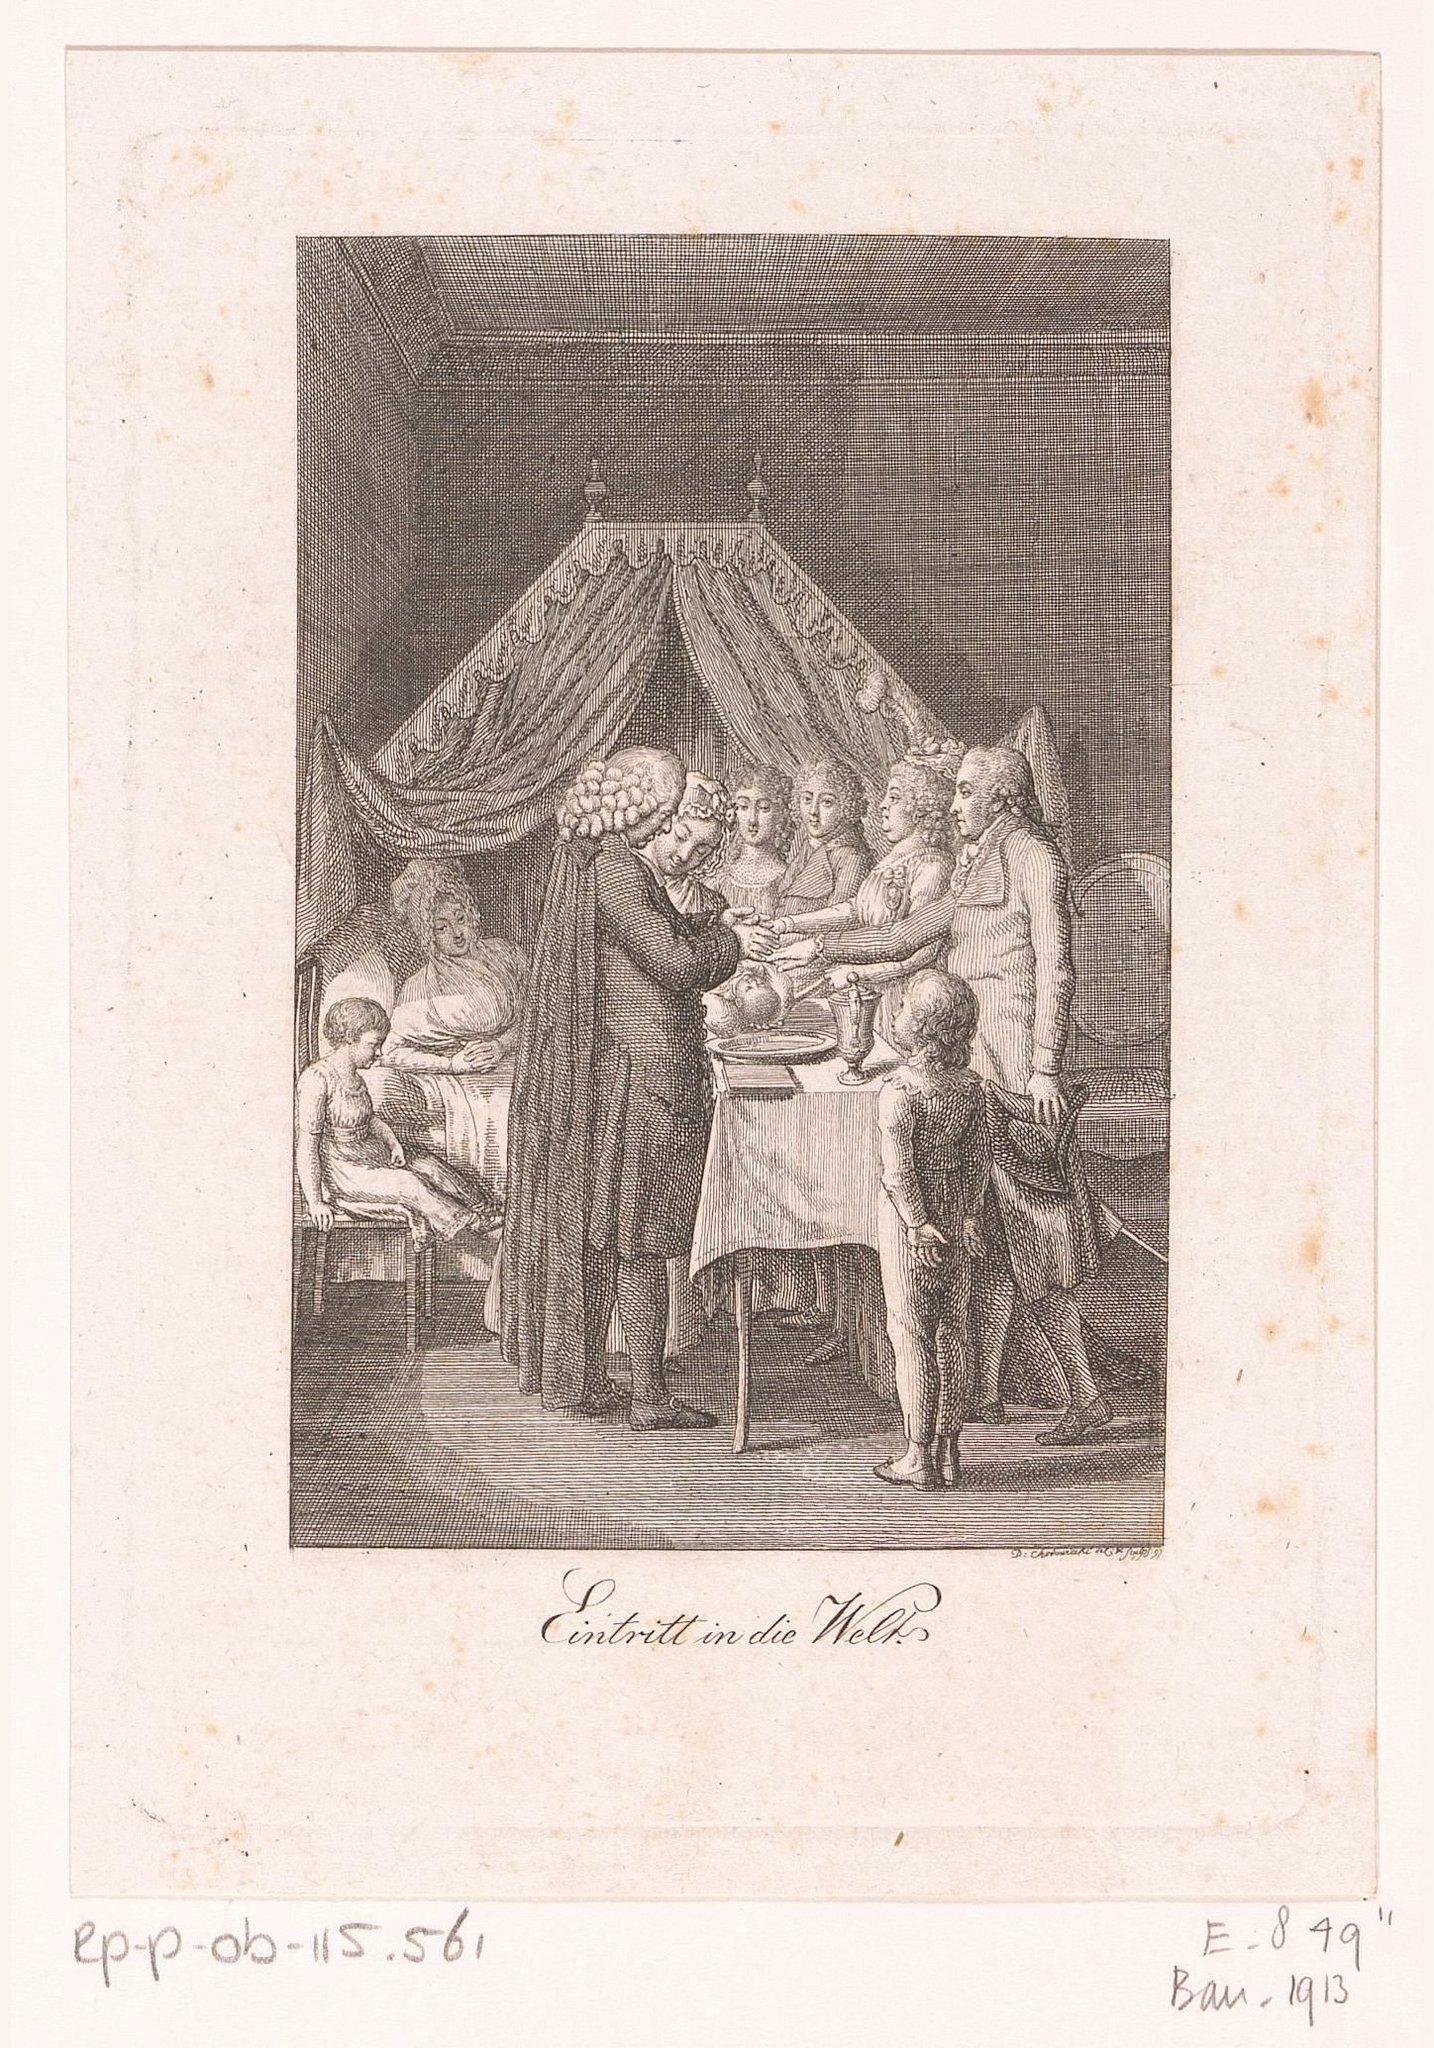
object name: print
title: Doop van het nieuwgeboren kind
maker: daniel nikolaus chodowiecki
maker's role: draughtsman, print maker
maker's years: 1726-1801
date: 1797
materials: paper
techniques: etching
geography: berlin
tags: baptism, christening ceremony ~ the first of the seven sacraments, lying-in room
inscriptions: collector's mark: Lugt 2228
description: Prent gebruikt voor: Lang, Karl. Almanach und Taschenbuch für Häusliche und Gesellschaftl. Freuden (...). Heilbronn: Industrie Comtoir, s.a.